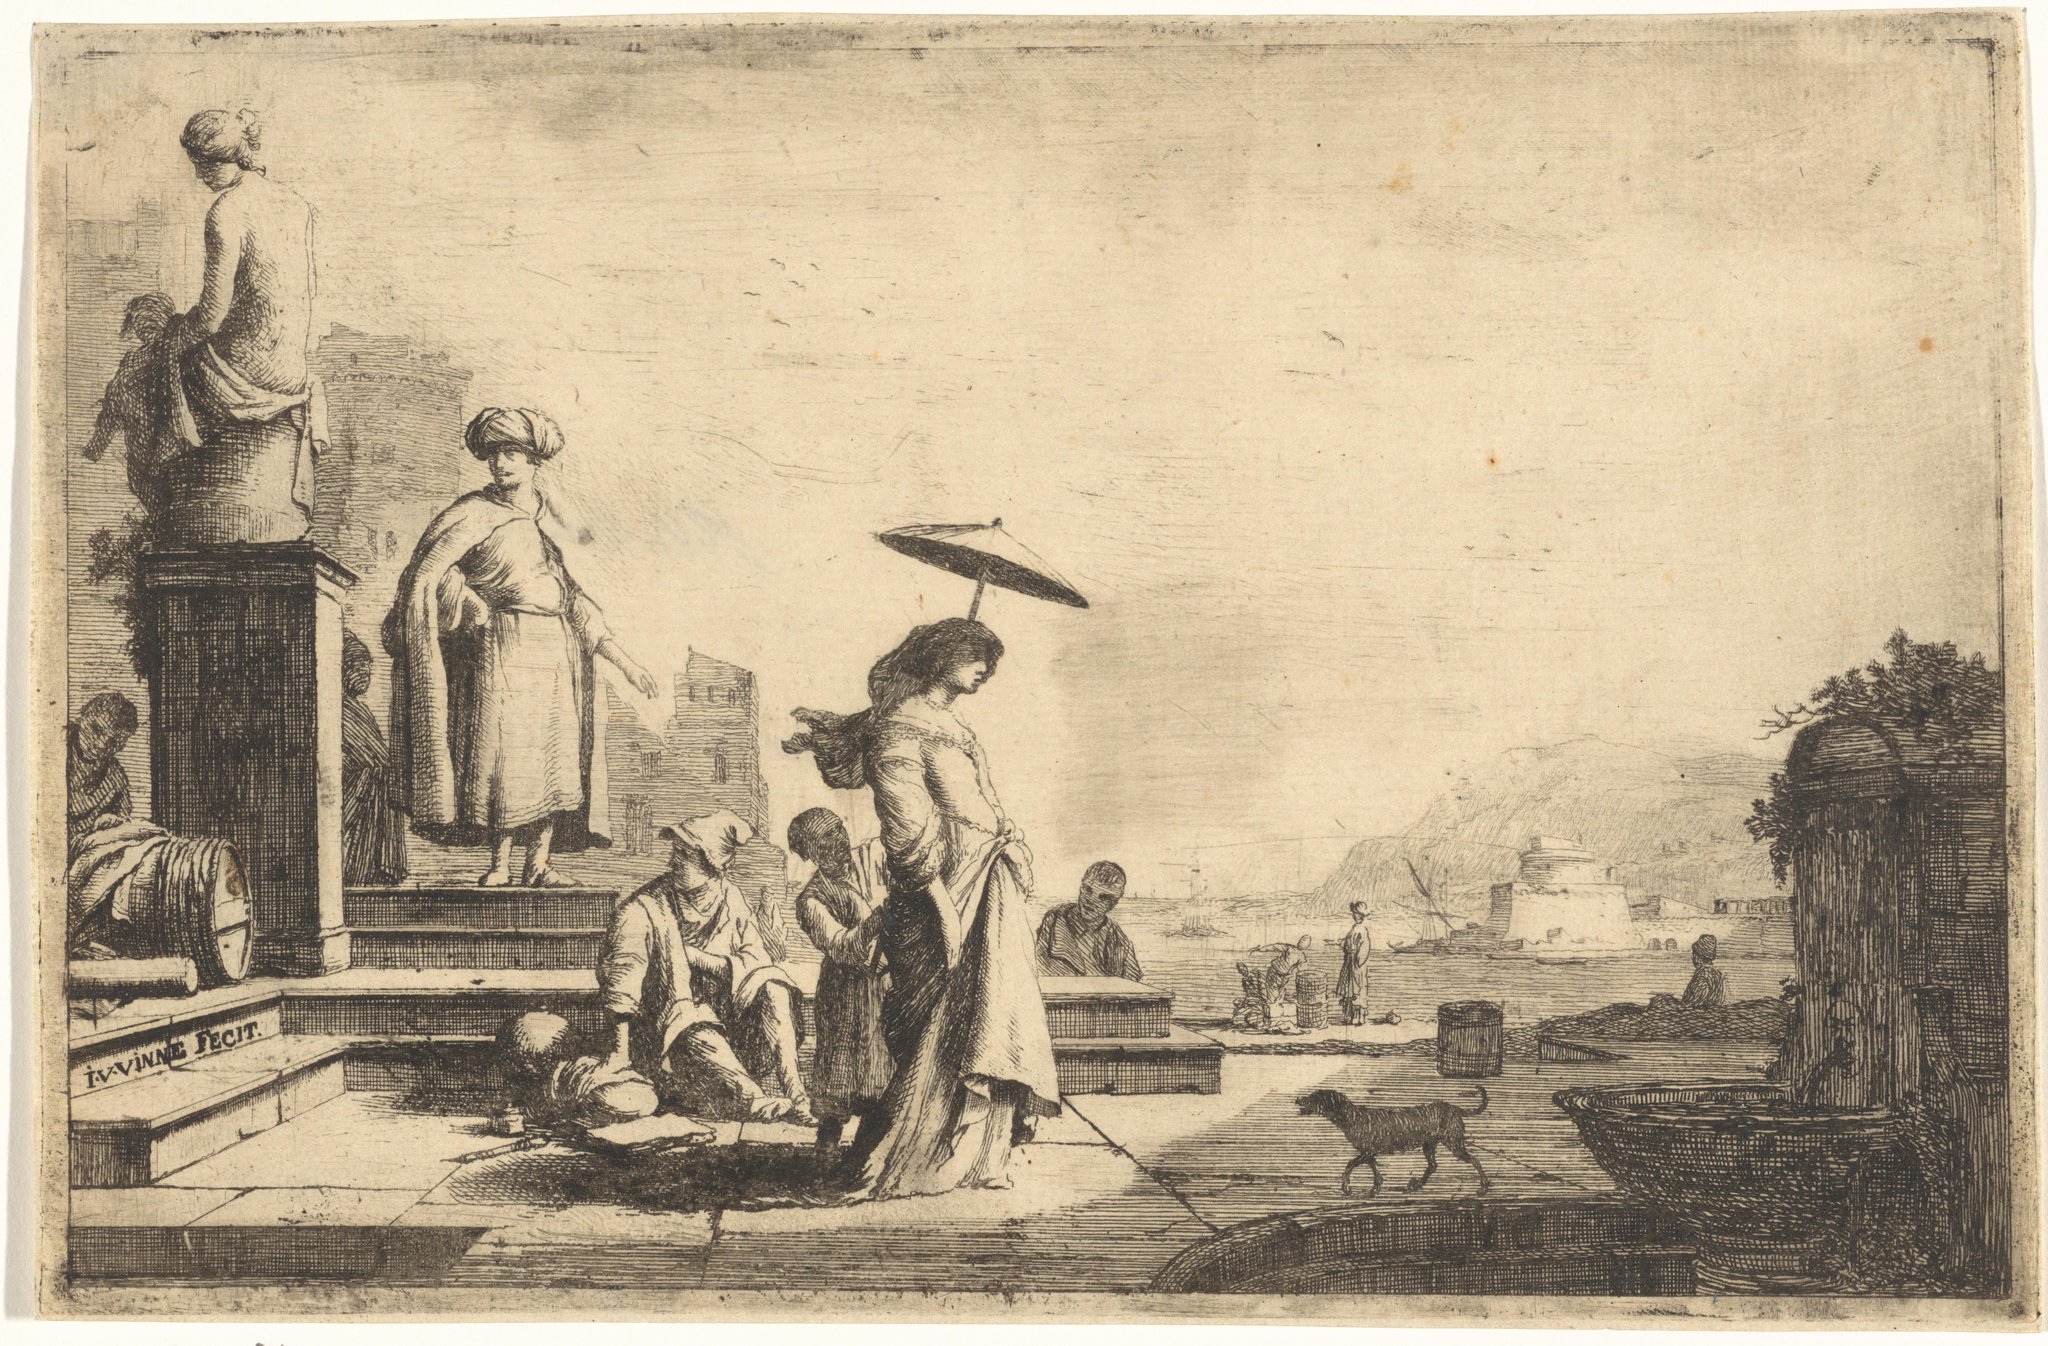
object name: print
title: Gezicht op een mediterrane haven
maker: isaac vincentsz. van der vinne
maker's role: draughtsman, print maker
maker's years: 1665-1740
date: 1690-1740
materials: paper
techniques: etching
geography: haarlem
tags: harbour, ornamental fountain (+ variant), head-gear: turban, parasol, sunshade, dog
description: Gezicht op een mediterrane zeehaven. In het midden staat een vrouw, een dienaar houdt een parasol boven haar hoofd. Links enkele trappen waarop een jongen zit en een man met tulband op het hoofd naast een sokkel met een beeld van een vrouw staat. Links van het piëdestal een jongen bij een ton. Rechts een fontein waarbij een hond.